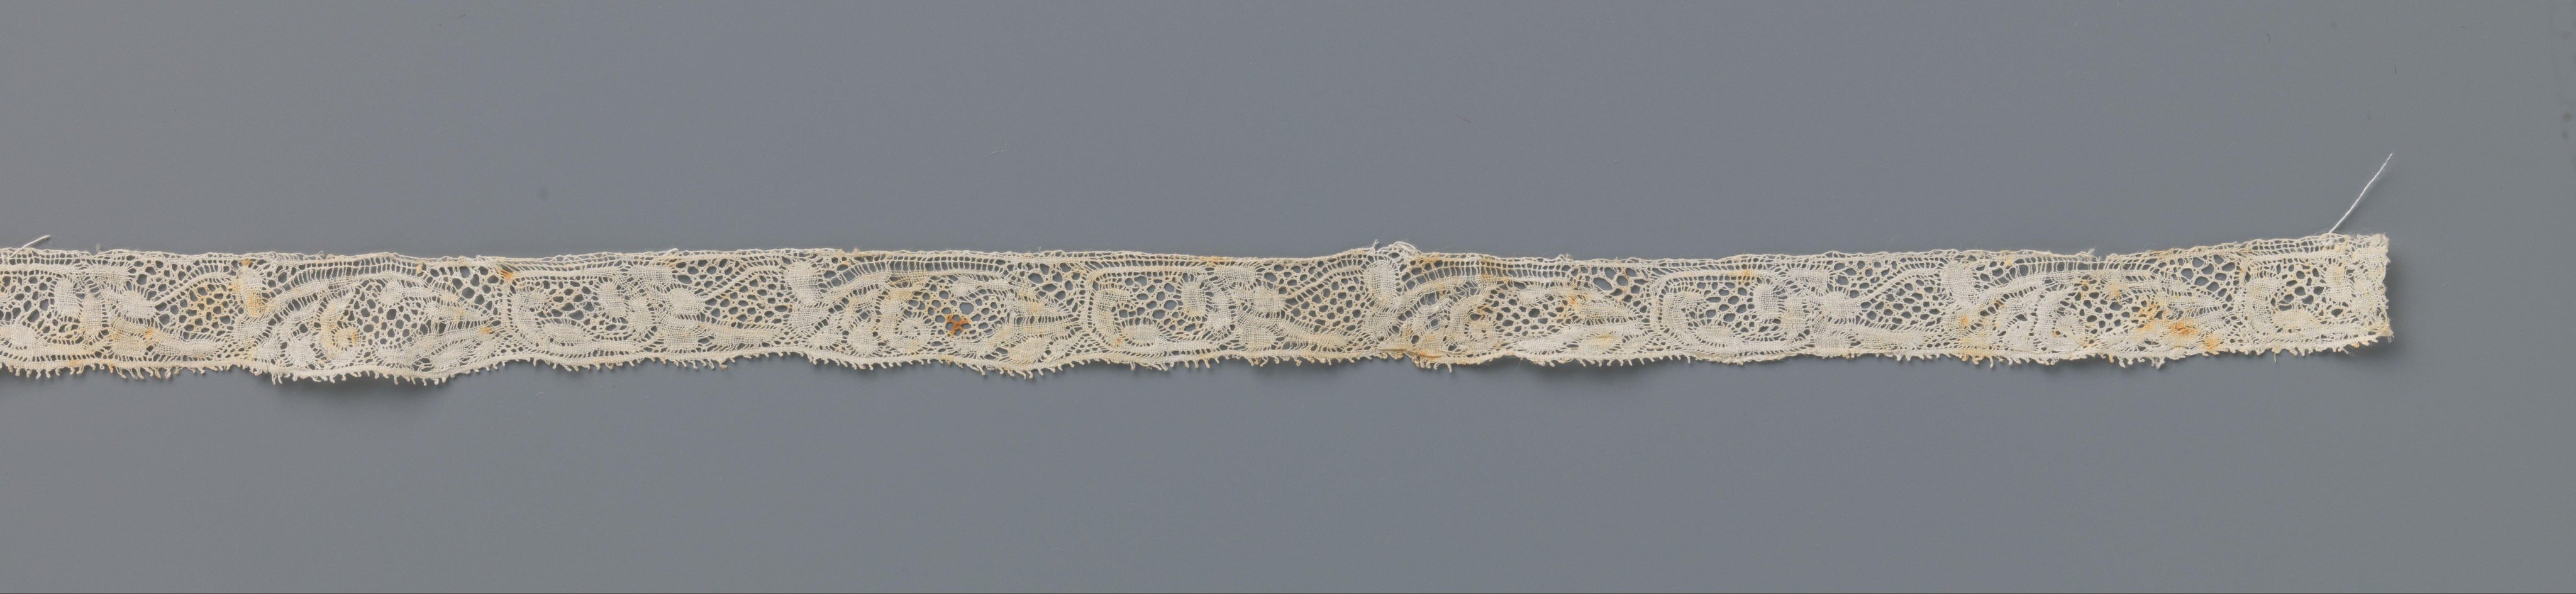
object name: strip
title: Strook kloskant met een blad dat een rechthoek vormt en een bloem aan een gebogen steel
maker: Anonymous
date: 1700-1799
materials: linen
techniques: lace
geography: flanders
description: Strook naturelkleurige kloskant, oudvlaamse kant. Het zich herhalende en doorlopende patroon bestaat uit een gebogen steel met een kelkvormige bloem aan het uiteinde en aan het begin een pluimvormig blad dat zich in tegengestelde richting afsplitst en een soort rechthoek met afgeronde hoeken vormt. De motieven zijn met elkaar verbonden door een traliegrond, een vijfgaatjesgrond. De motieven zijn gemaakt in linnenslag met opengewerkte randjes. De boven- en onderzijde zijn recht afgewerkt, waarbij de onderzijde is voorzien van picots.